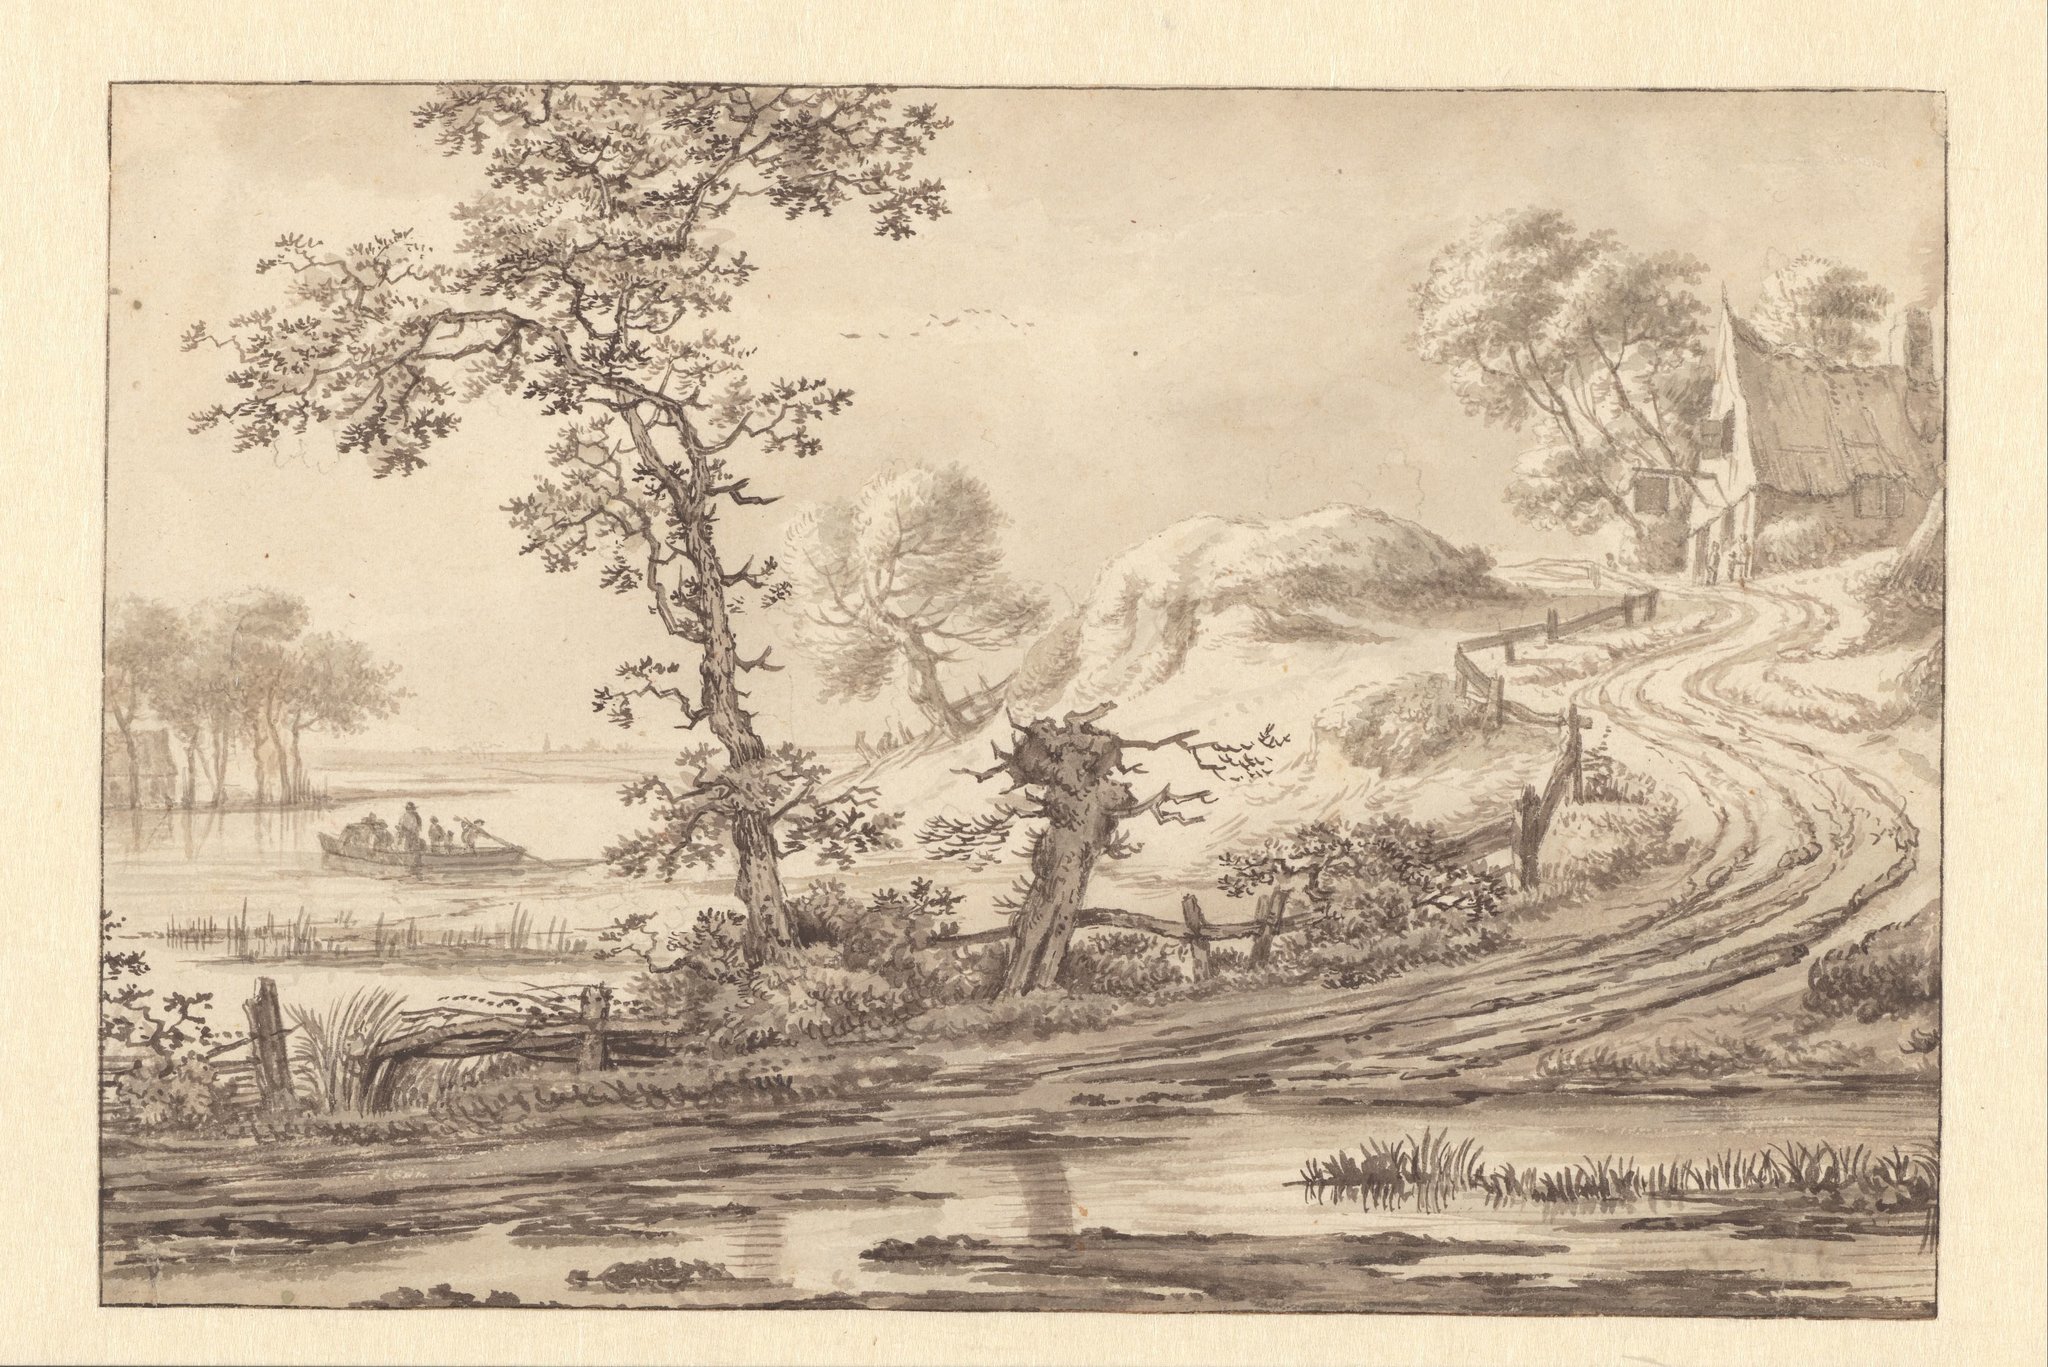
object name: drawing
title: Country Road with an Inn on a Hill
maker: jan van kessel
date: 1660-1680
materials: ink, paper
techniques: brush, pen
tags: river, ferry, farm or solitary house in landscape, hotel, hostelry, inn